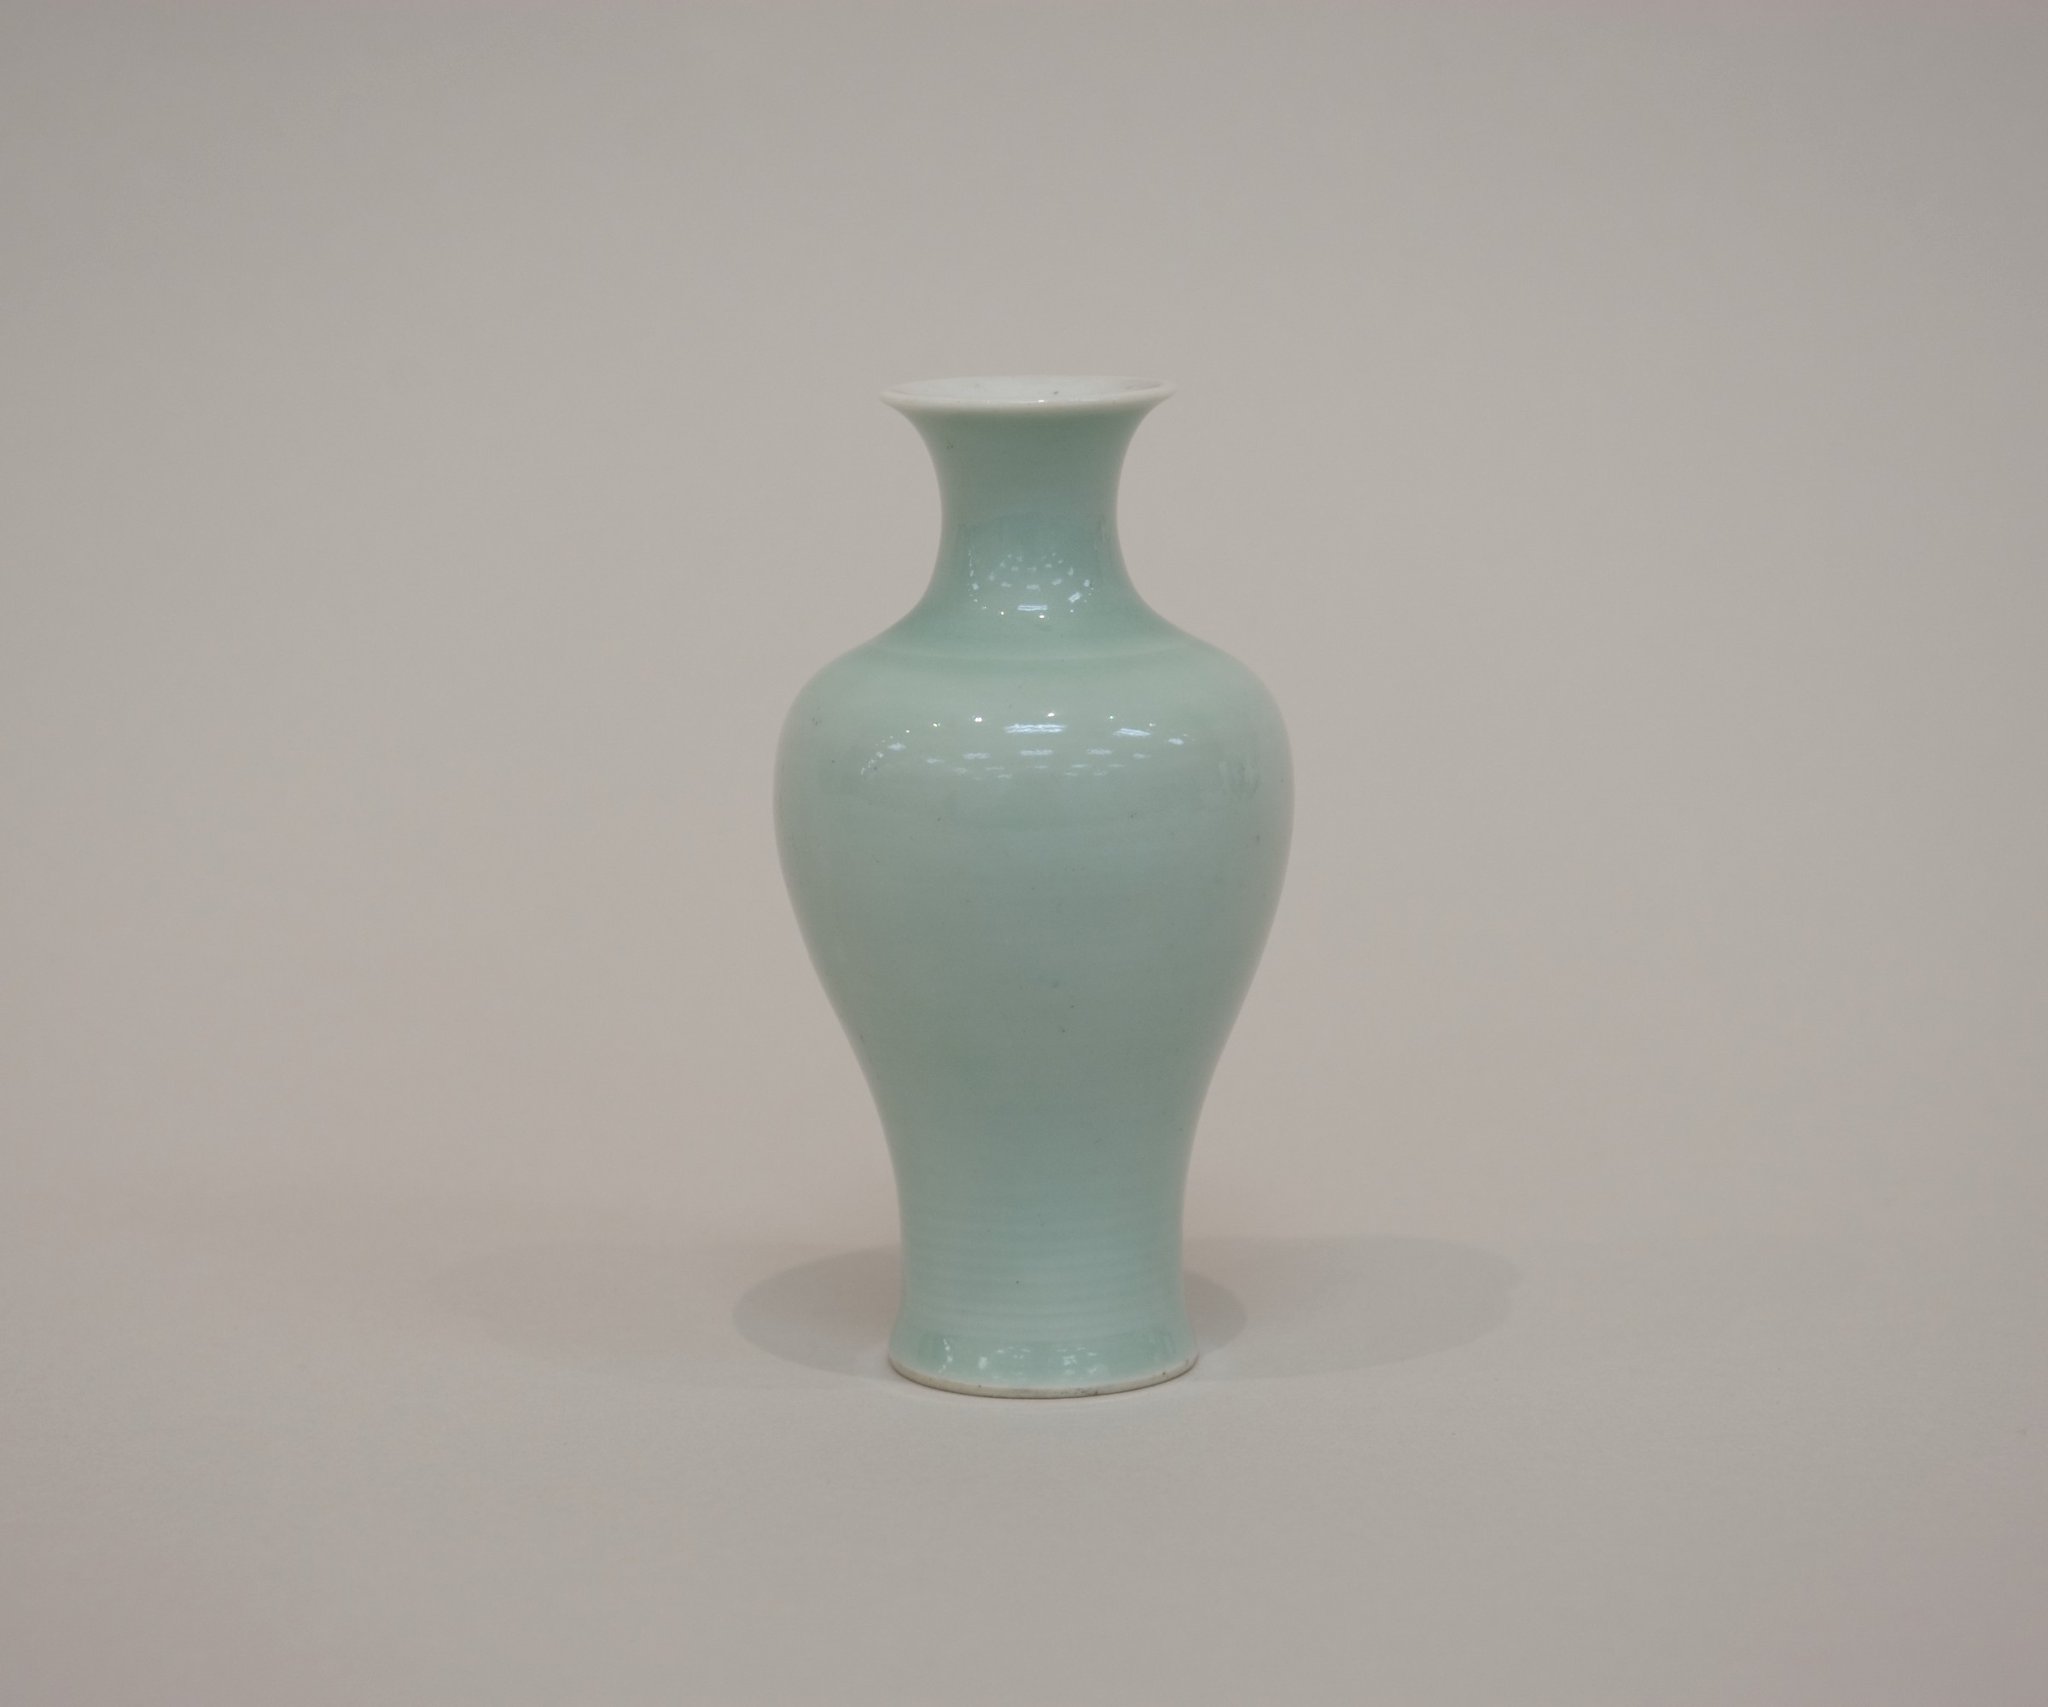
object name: vase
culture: chinese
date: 1767-1800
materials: glaze, porcelain